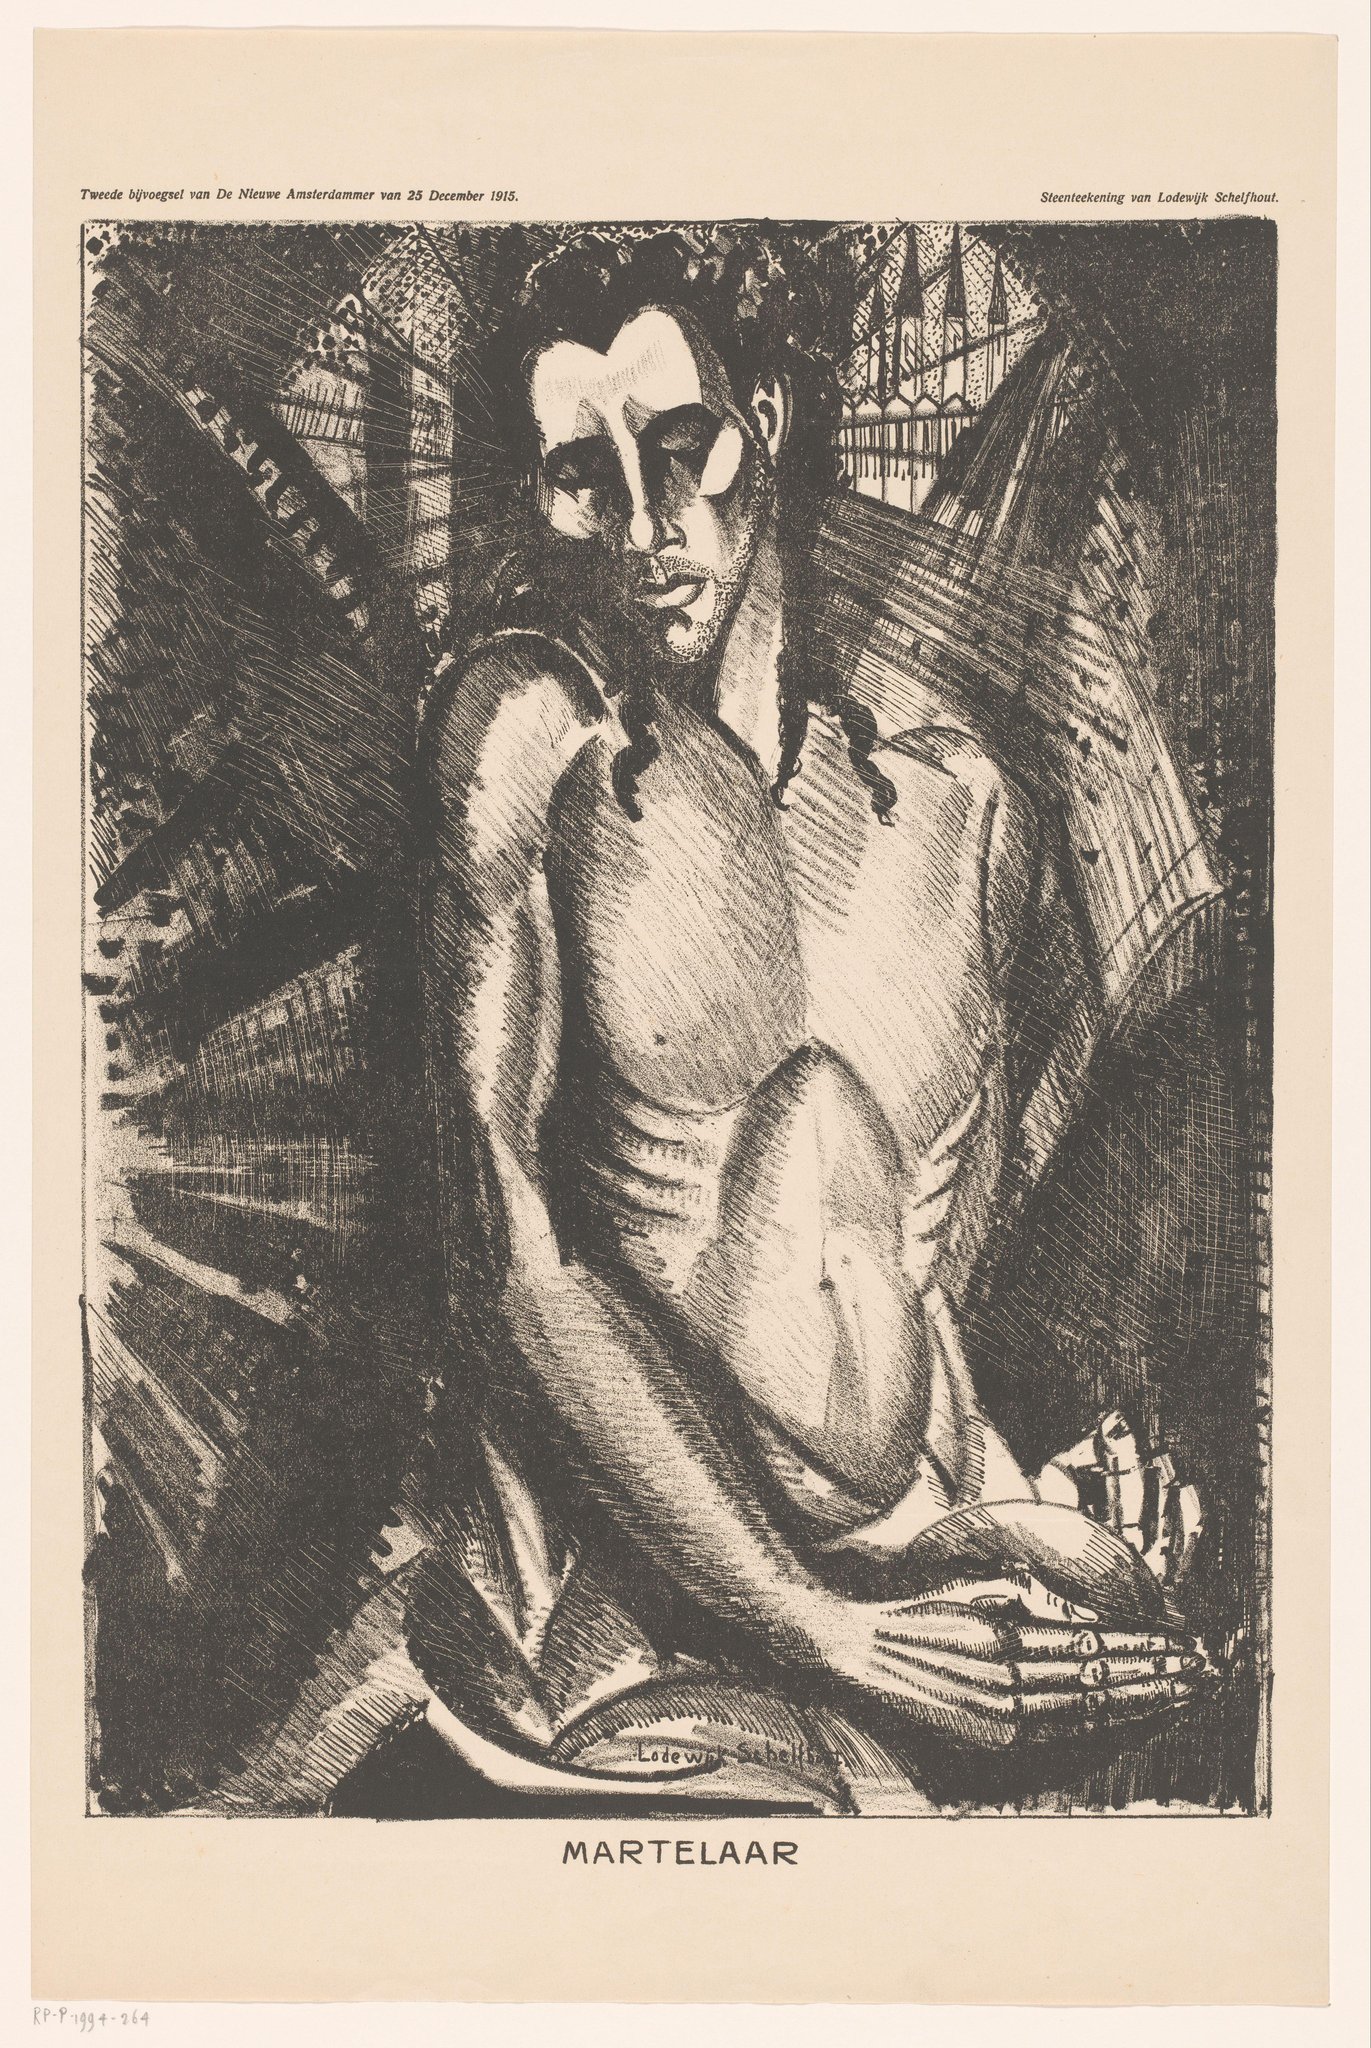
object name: print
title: Martelaar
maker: lodewijk schelfhout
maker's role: draughtsman, print maker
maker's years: 1881-1943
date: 1915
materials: paper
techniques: lithograph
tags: christ as adult, martyr(s) (often with palm-branches)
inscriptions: collector's mark: Lugt 2228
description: Prent gebruikt voor: De nieuwe Amsterdammer, Onafhankelijk Nederlandsch weekblad. Amsterdam: Maatschappij voor Goede en Goedkope Lectuur, 25 december 1915.